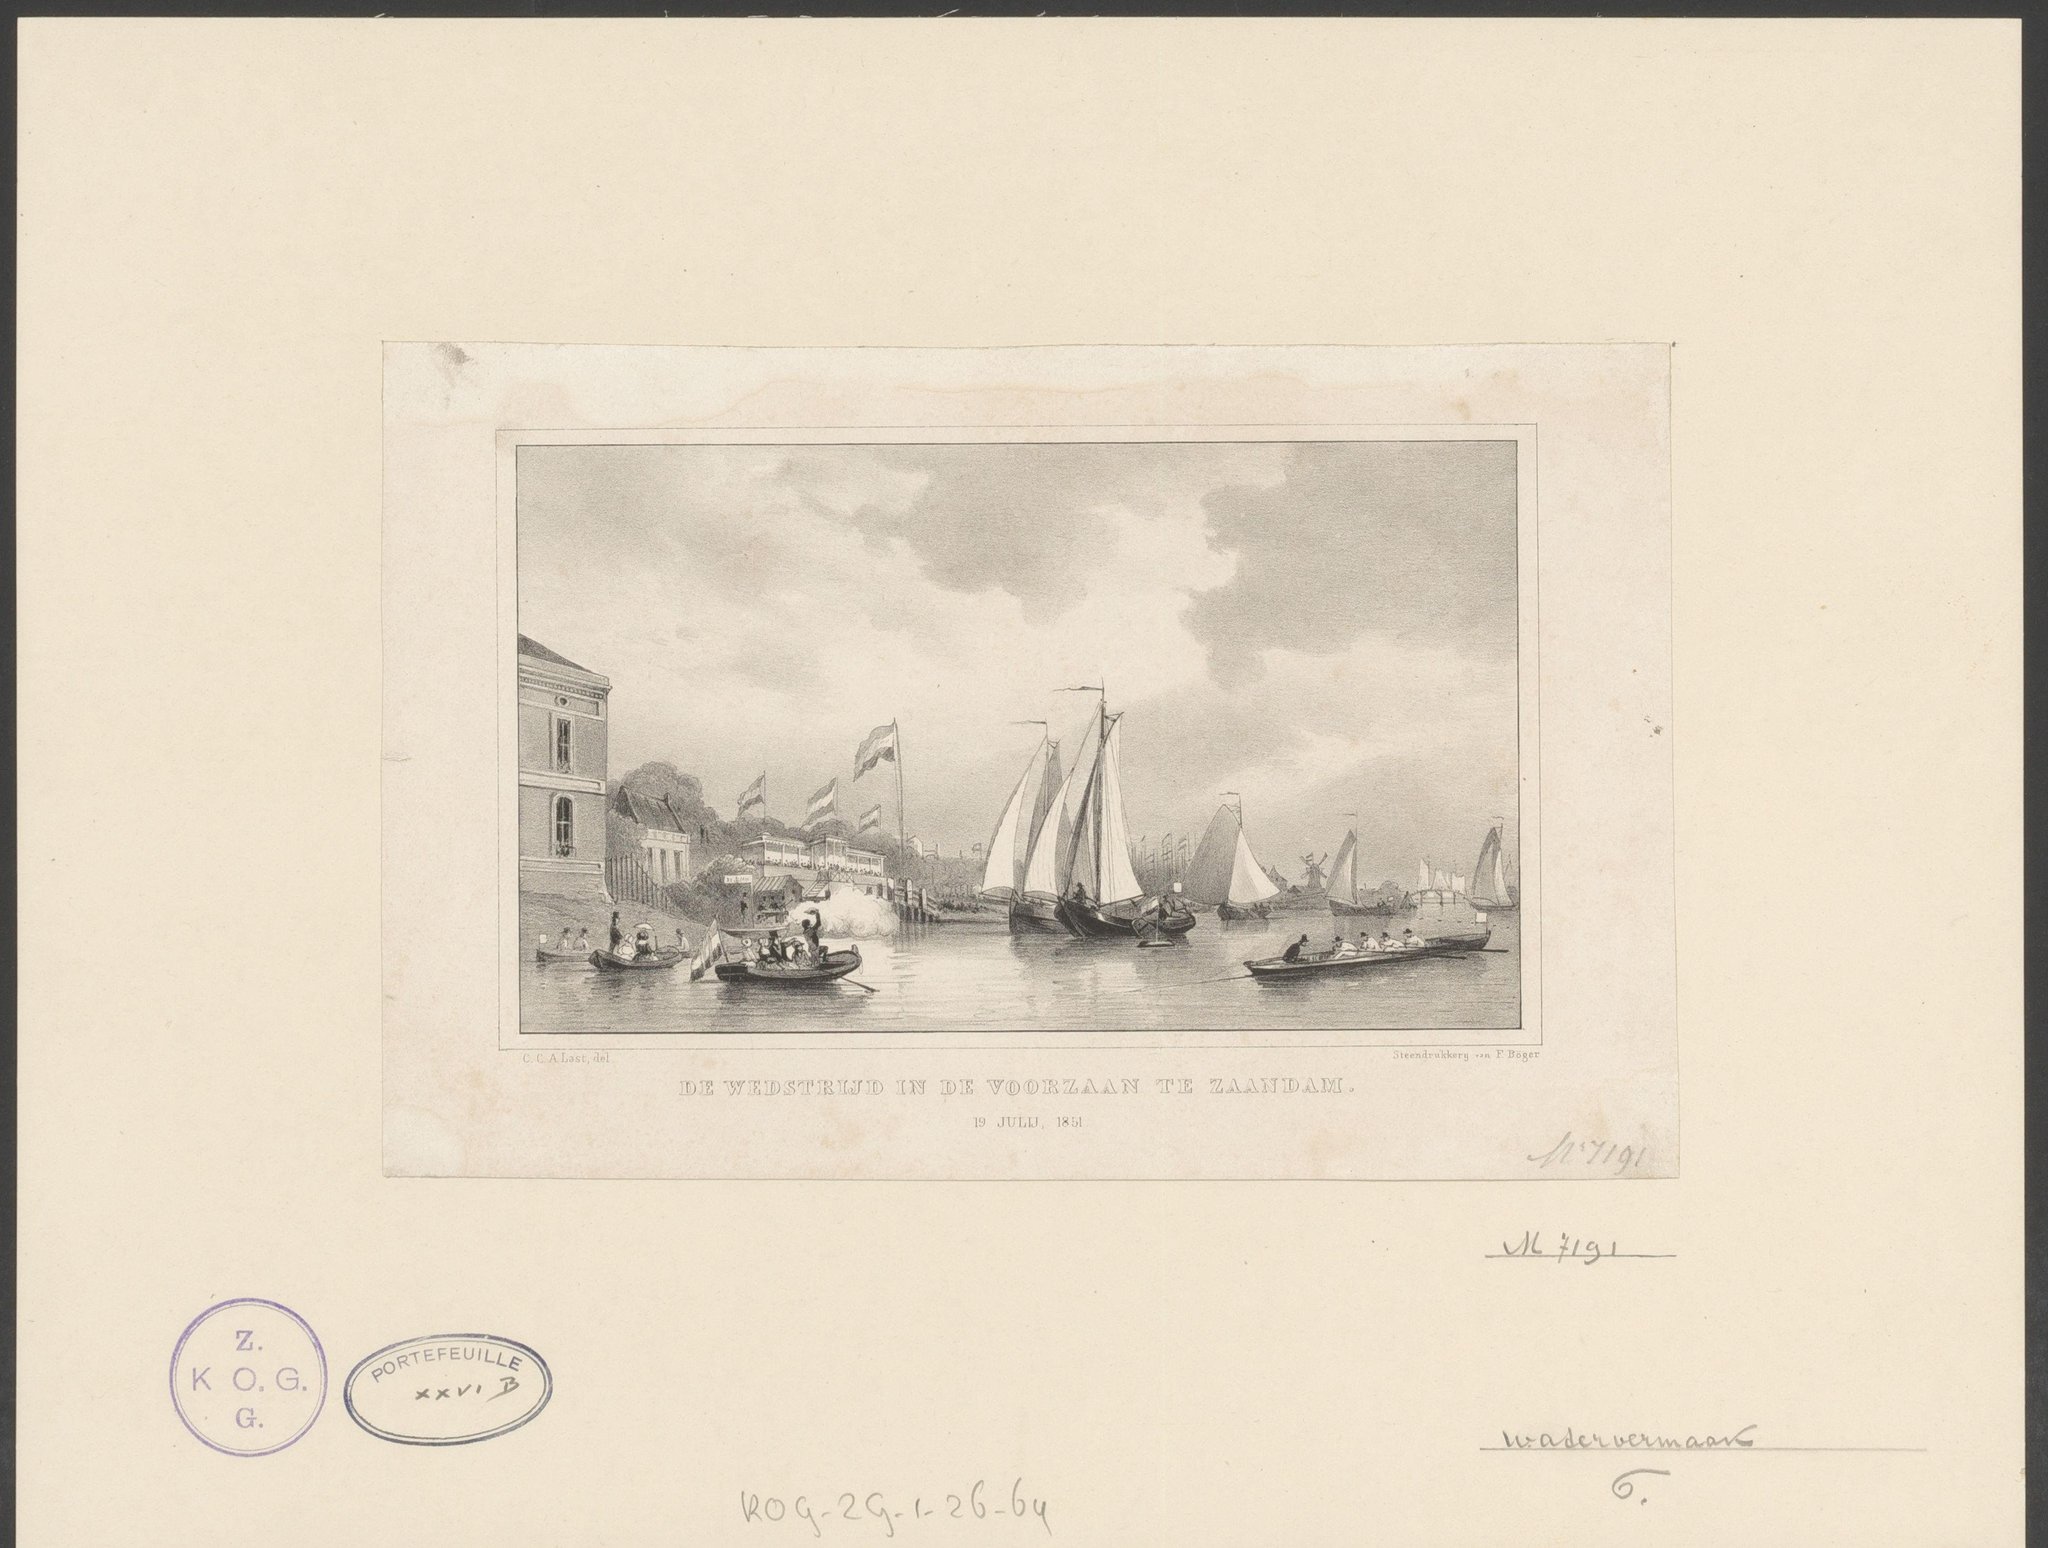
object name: print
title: De wedstrijd in de Voorzaan te Zaandam. 19 julij 1851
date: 1851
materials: paper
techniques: lithograph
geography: netherlands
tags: sailing (sport) (+ the contest (sports, games, etc.))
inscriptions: collector's mark: Lugt 1641, collector's mark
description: Zeilwedstrijd in de Voorzaan te Zaandam op 19 juli 1851. Links de publieke tribune versierd met vlaggen, met een kanonschot wordt de winnaar afgeschoten. Onderwerpsrubrieken binnen de Atlas Zeden en Gewoonten: Spel en Vermaak; Watervermaak.